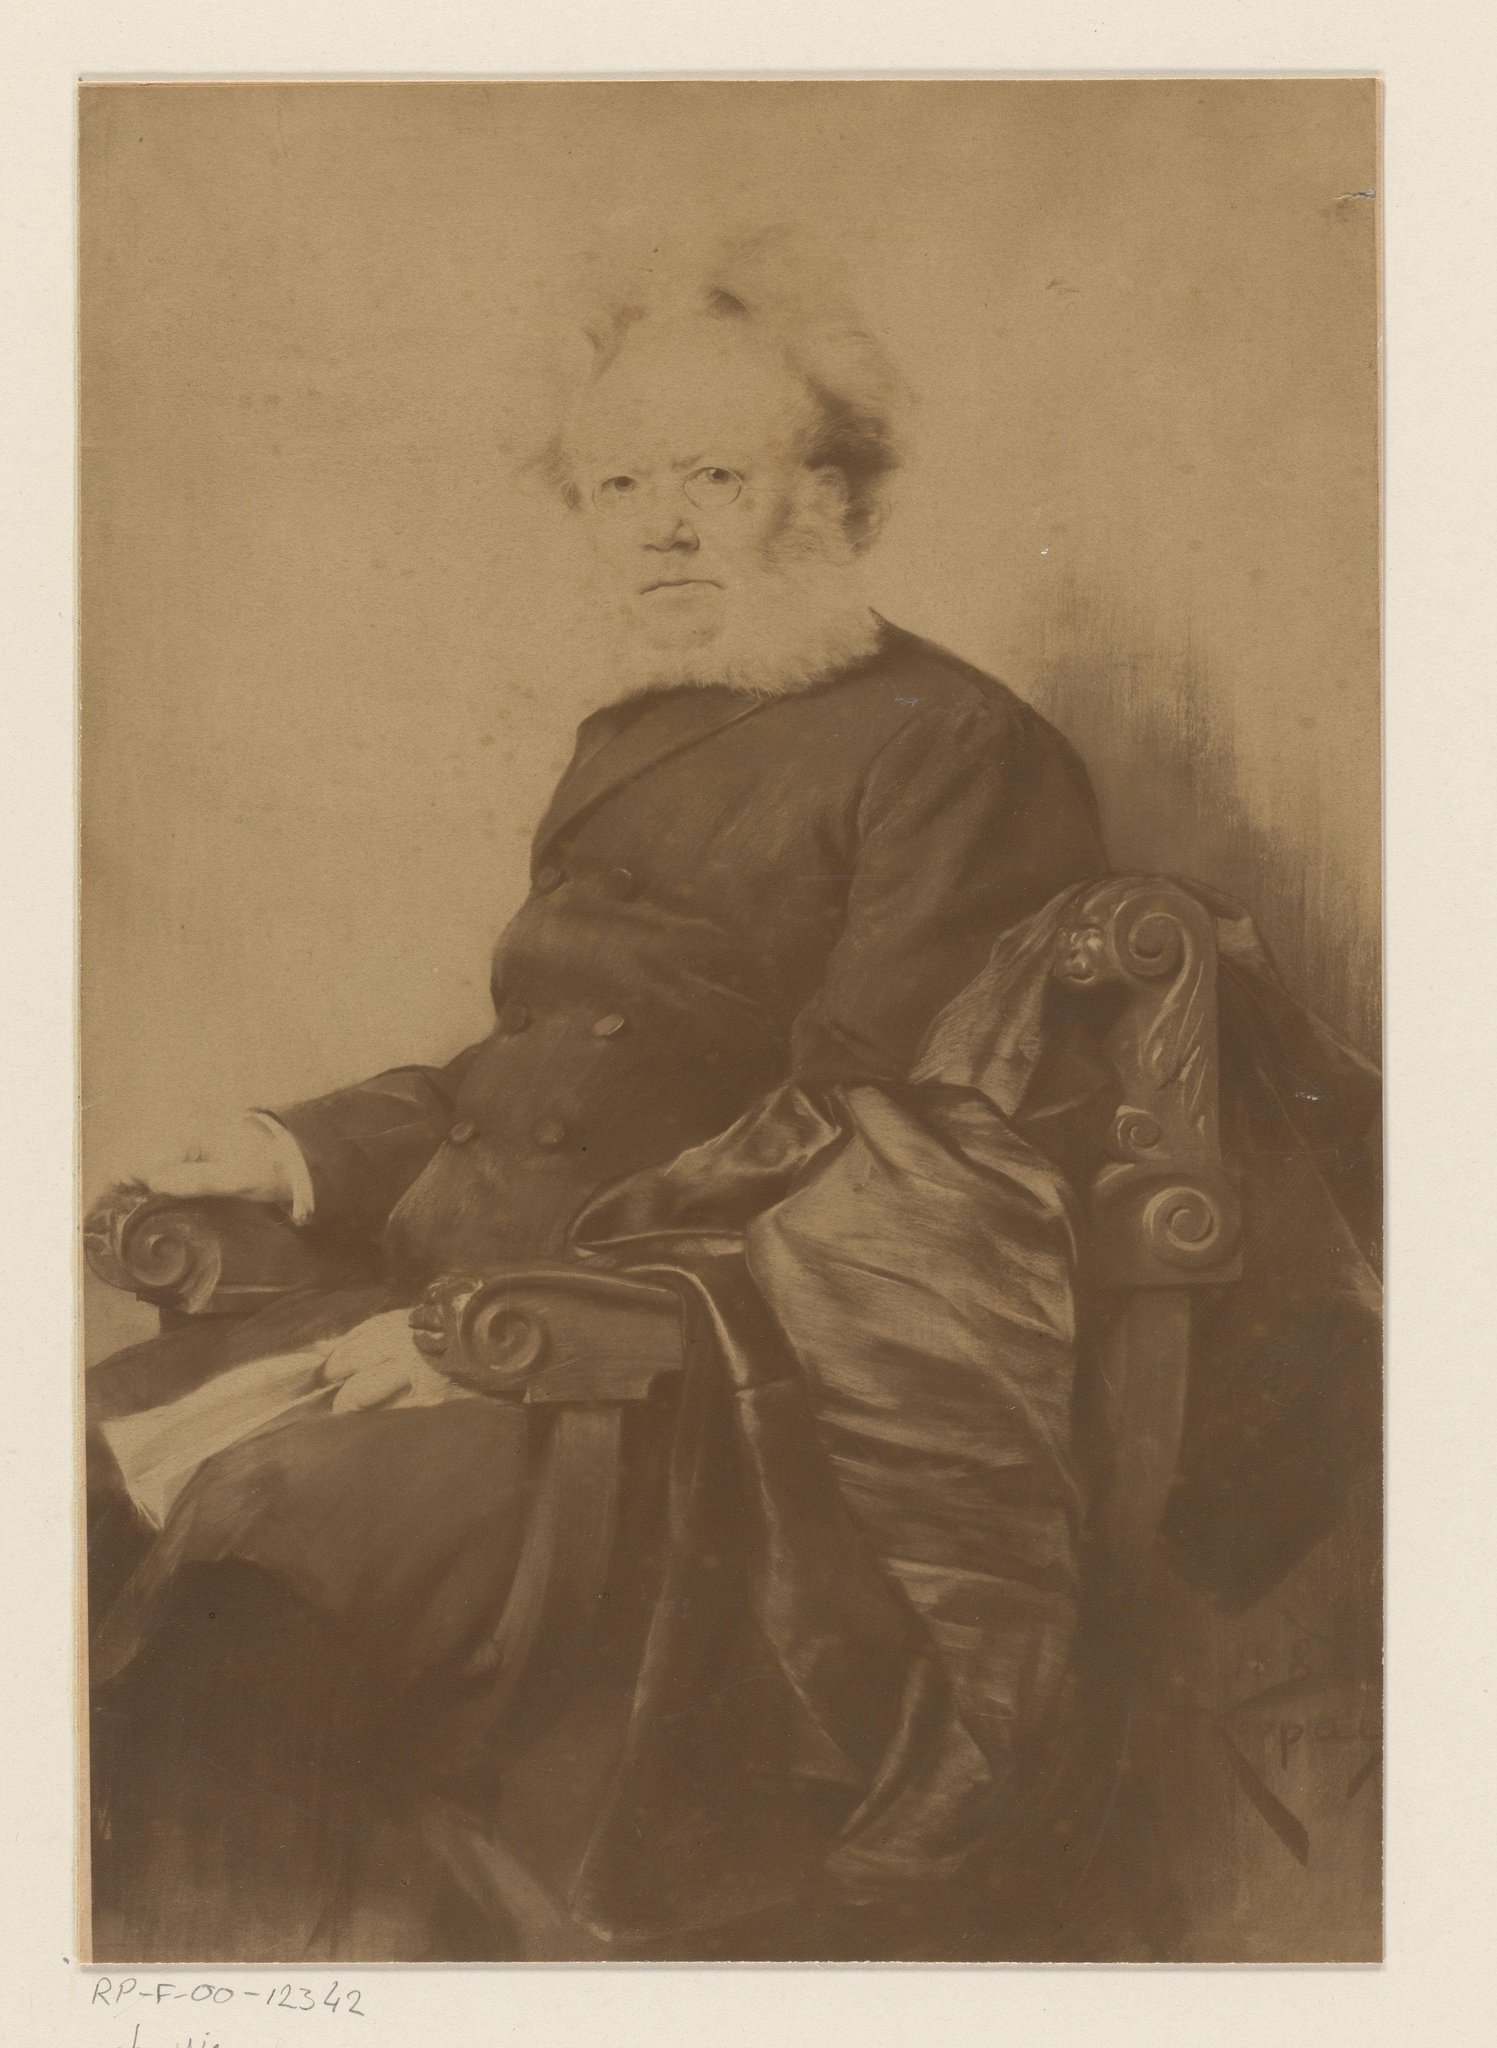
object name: reproduction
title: Fotoreproductie van een geschilderd portret van Henrik Ibsen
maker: Anonymous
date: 1900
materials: paper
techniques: albumen print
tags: historical persons